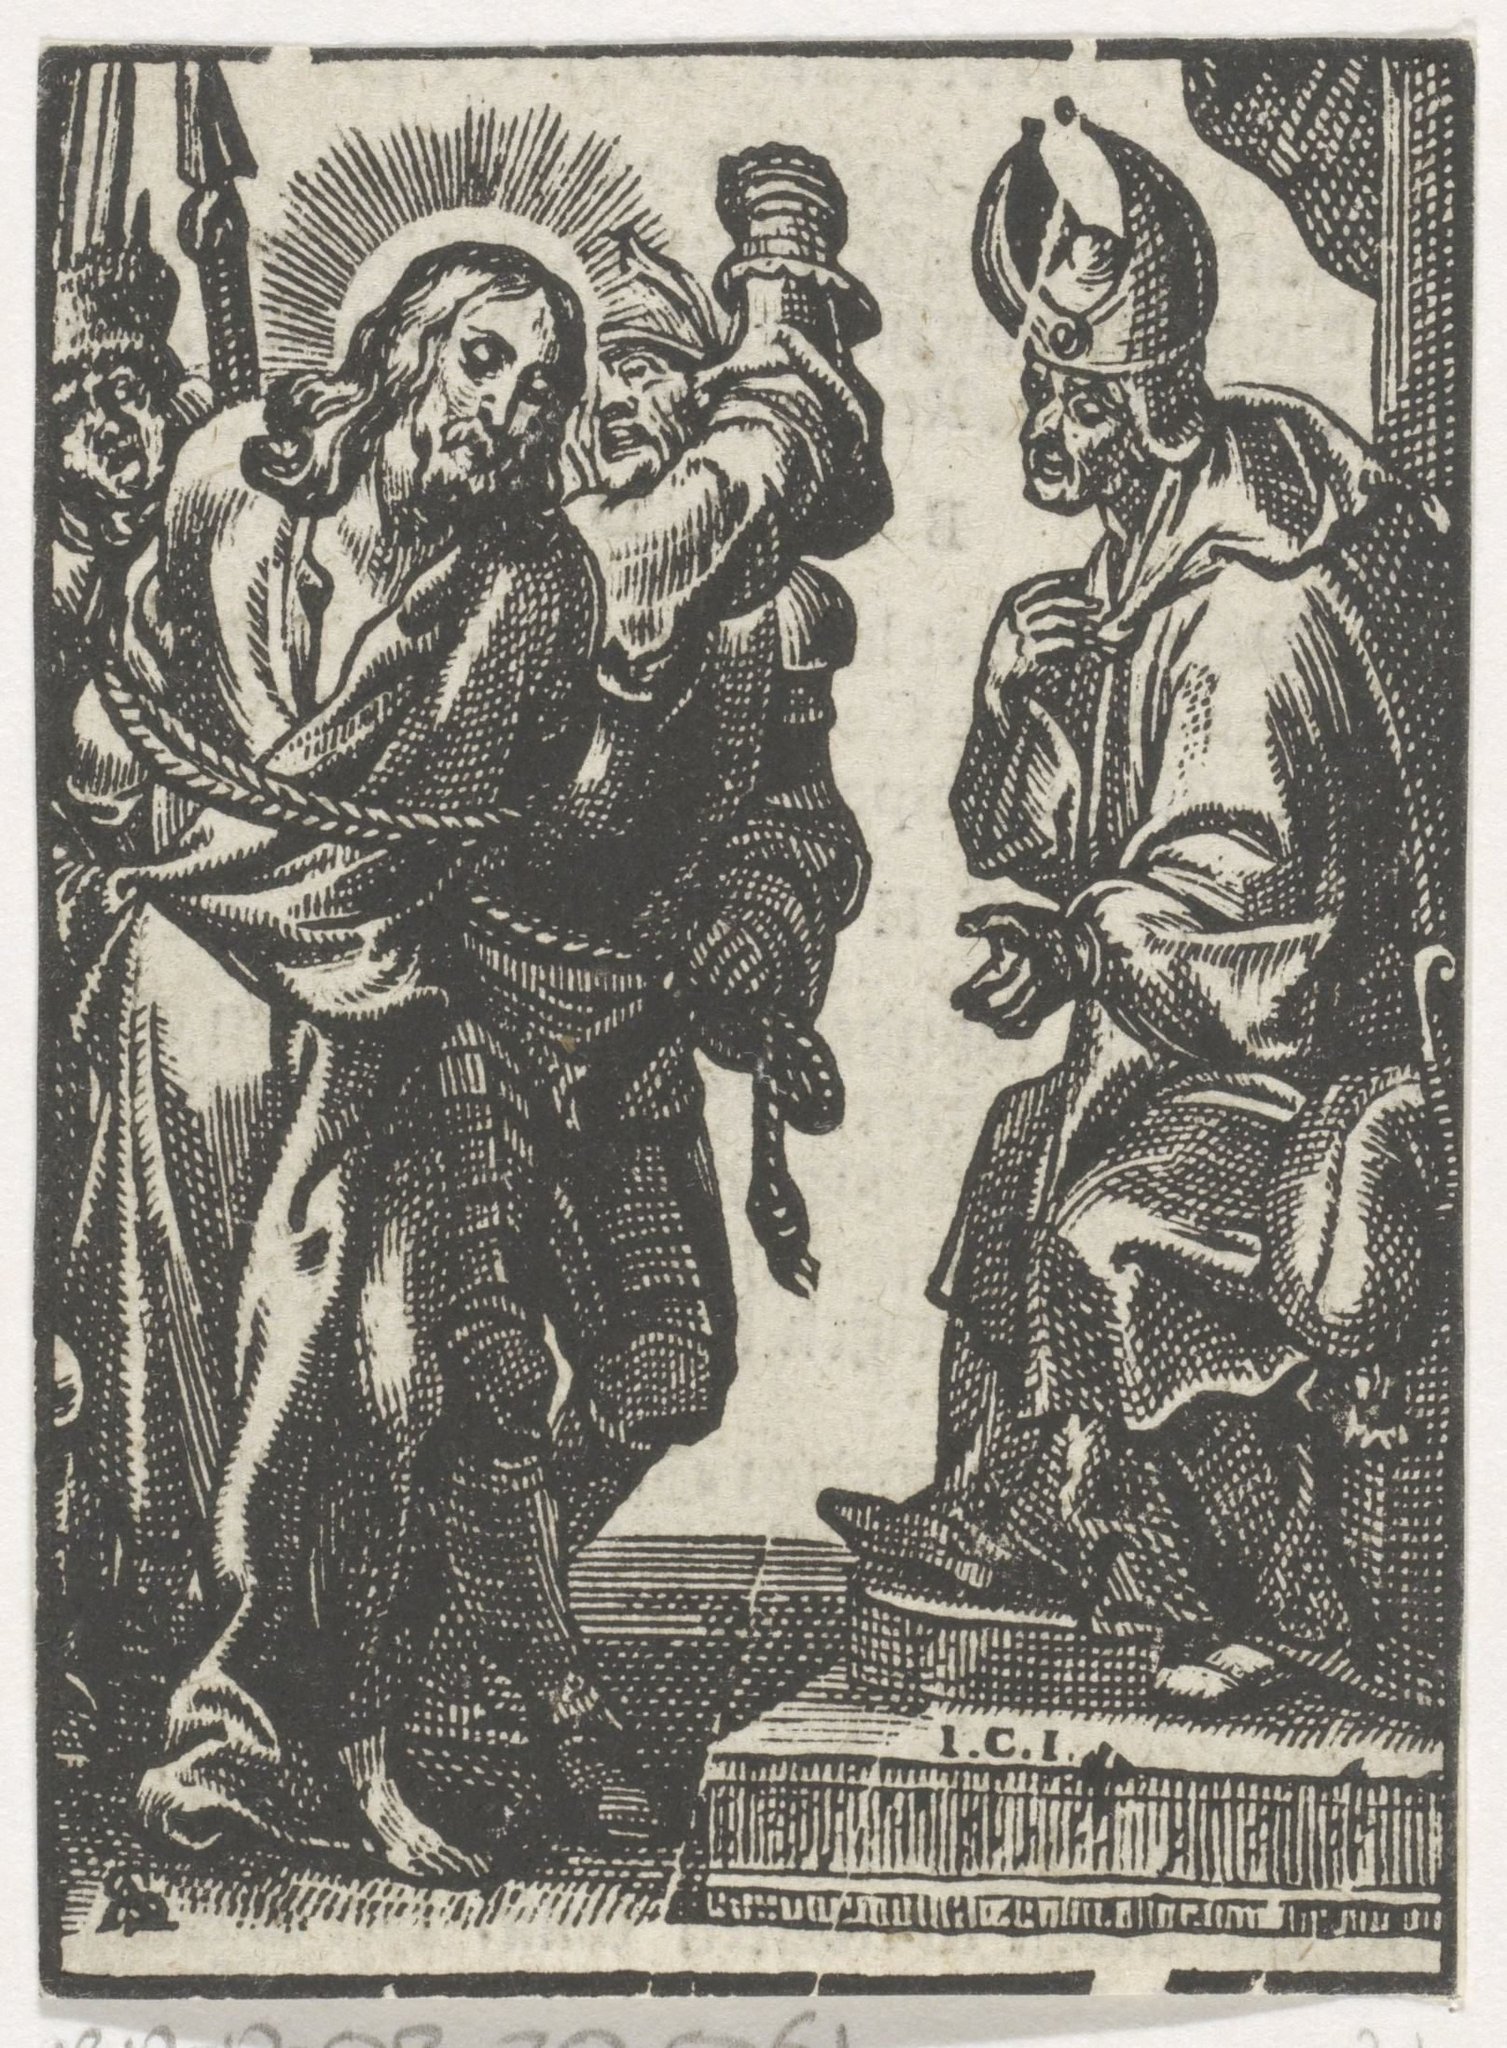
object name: print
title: Christus voor Annas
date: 1649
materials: paper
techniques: letterpress printing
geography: antwerp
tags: christ before annas (hanna); maybe a soldier about to strike christ (john 18:13, 18:19-24)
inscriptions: collector's mark: Lugt 2228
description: Christus wordt door gewapende soldaten voor de hogepriester Annas geleid. Eén van de soldaten staat op het punt Christus in het gezicht te slaan.